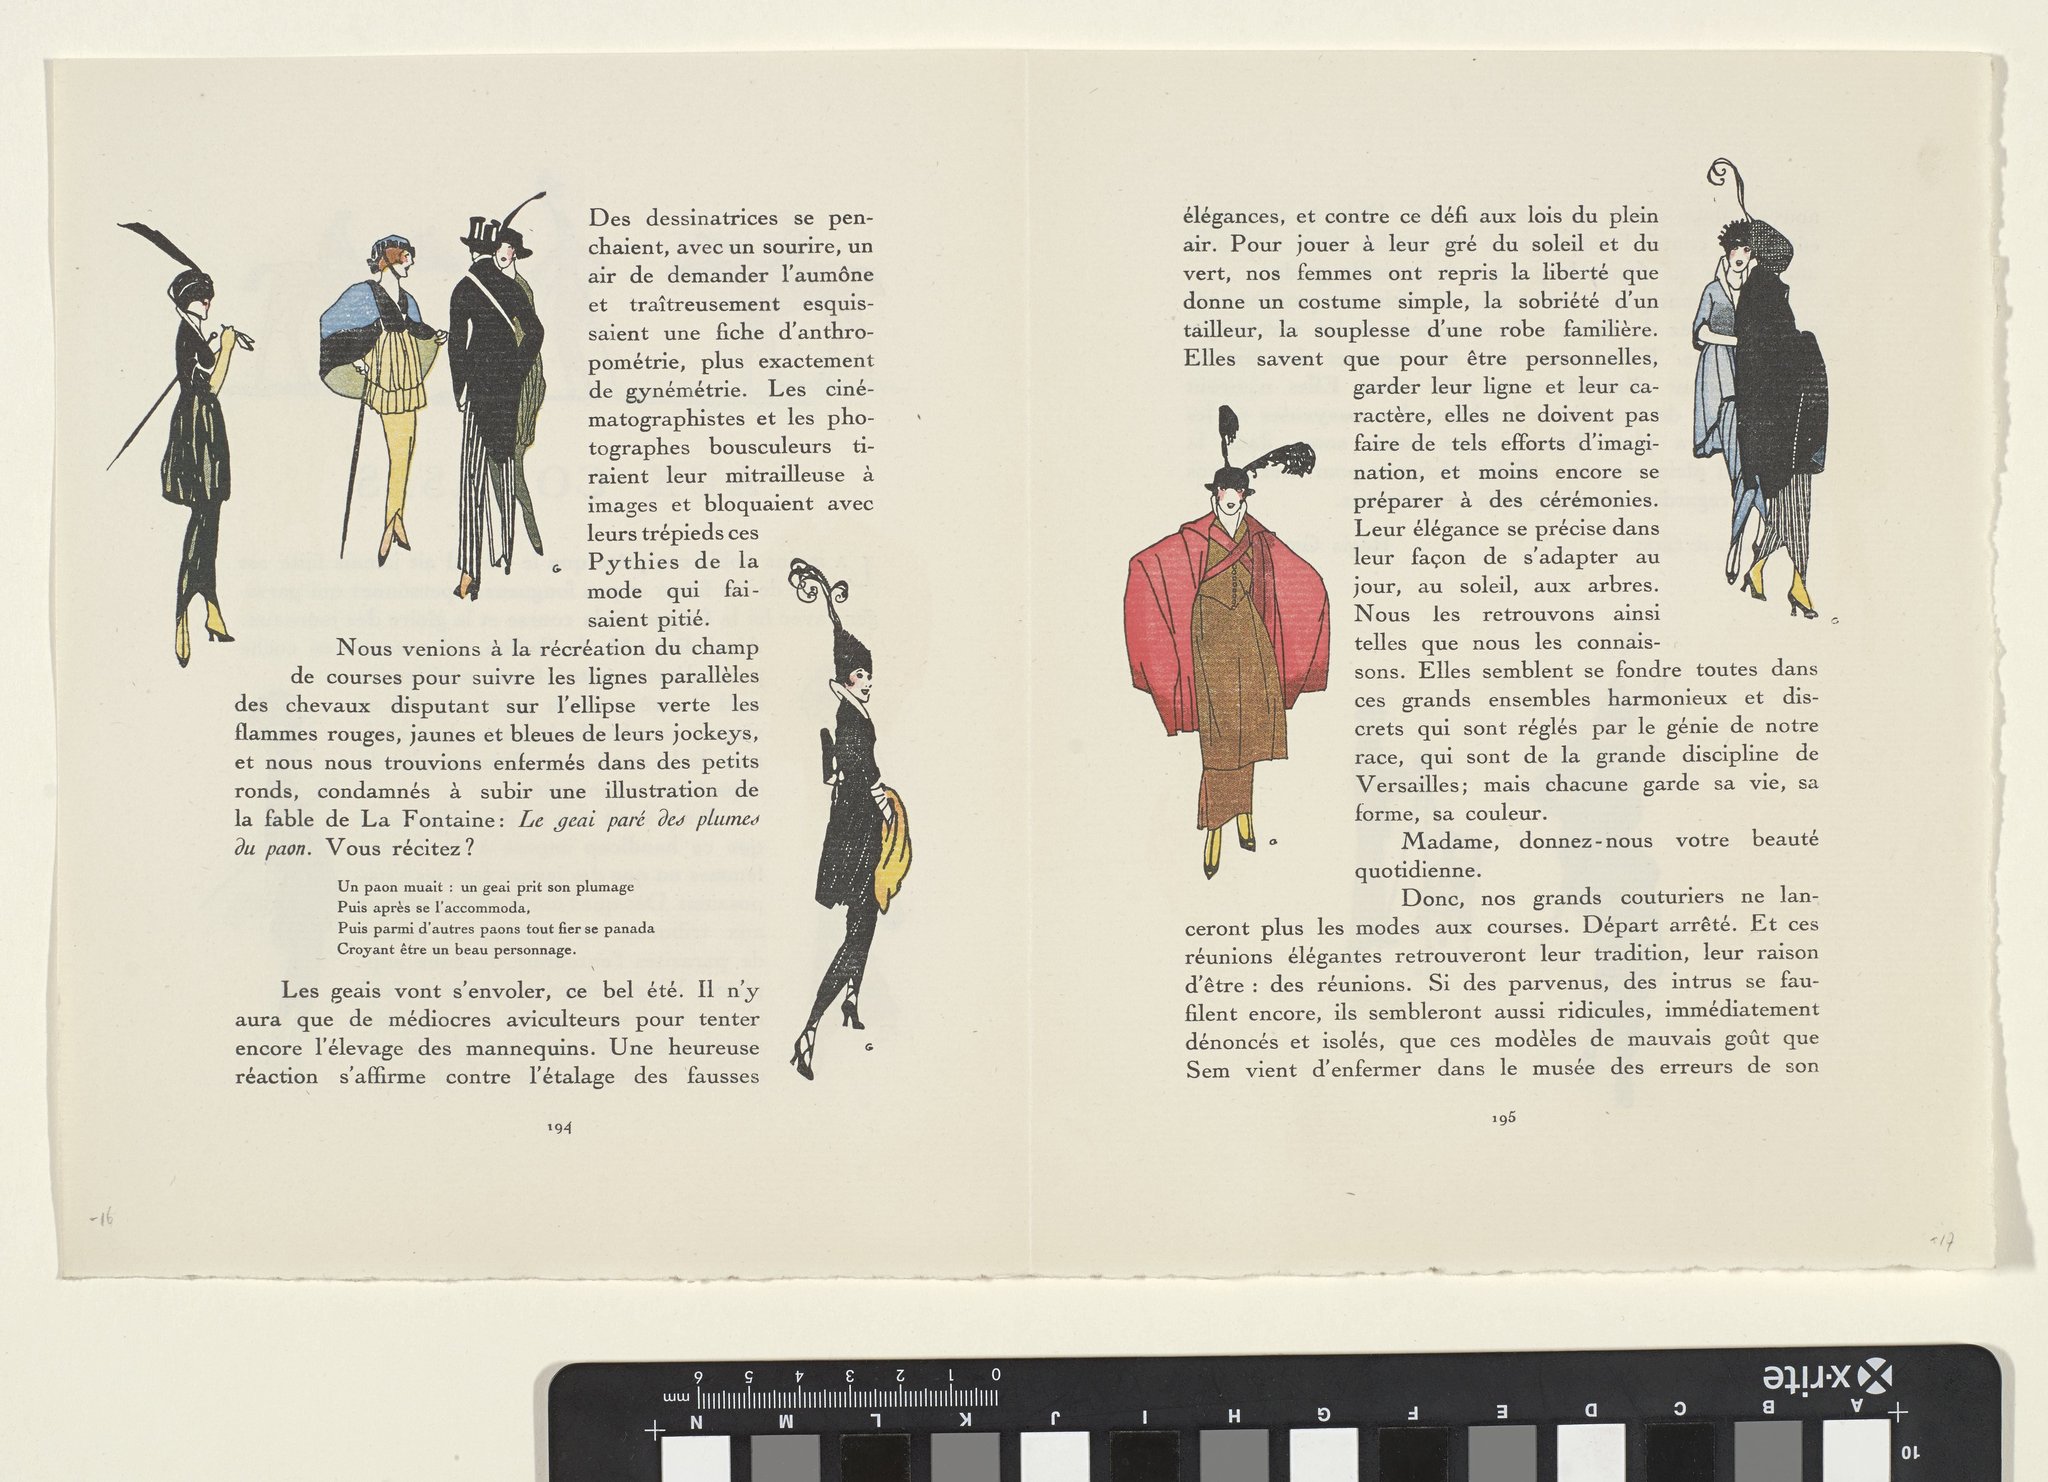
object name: fashion print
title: Gazette du Bon Ton, 1914 - No. 6, p. 194: Aux Courses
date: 1914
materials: paper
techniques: letterpress printing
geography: paris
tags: fashion plates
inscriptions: date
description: Aux Courses. Tekst en illustraties: vrouwen in modieuze ensembles voor de paardenrennen. Pagina 193 in Gazette du Bon Ton, 1914 - No. 6